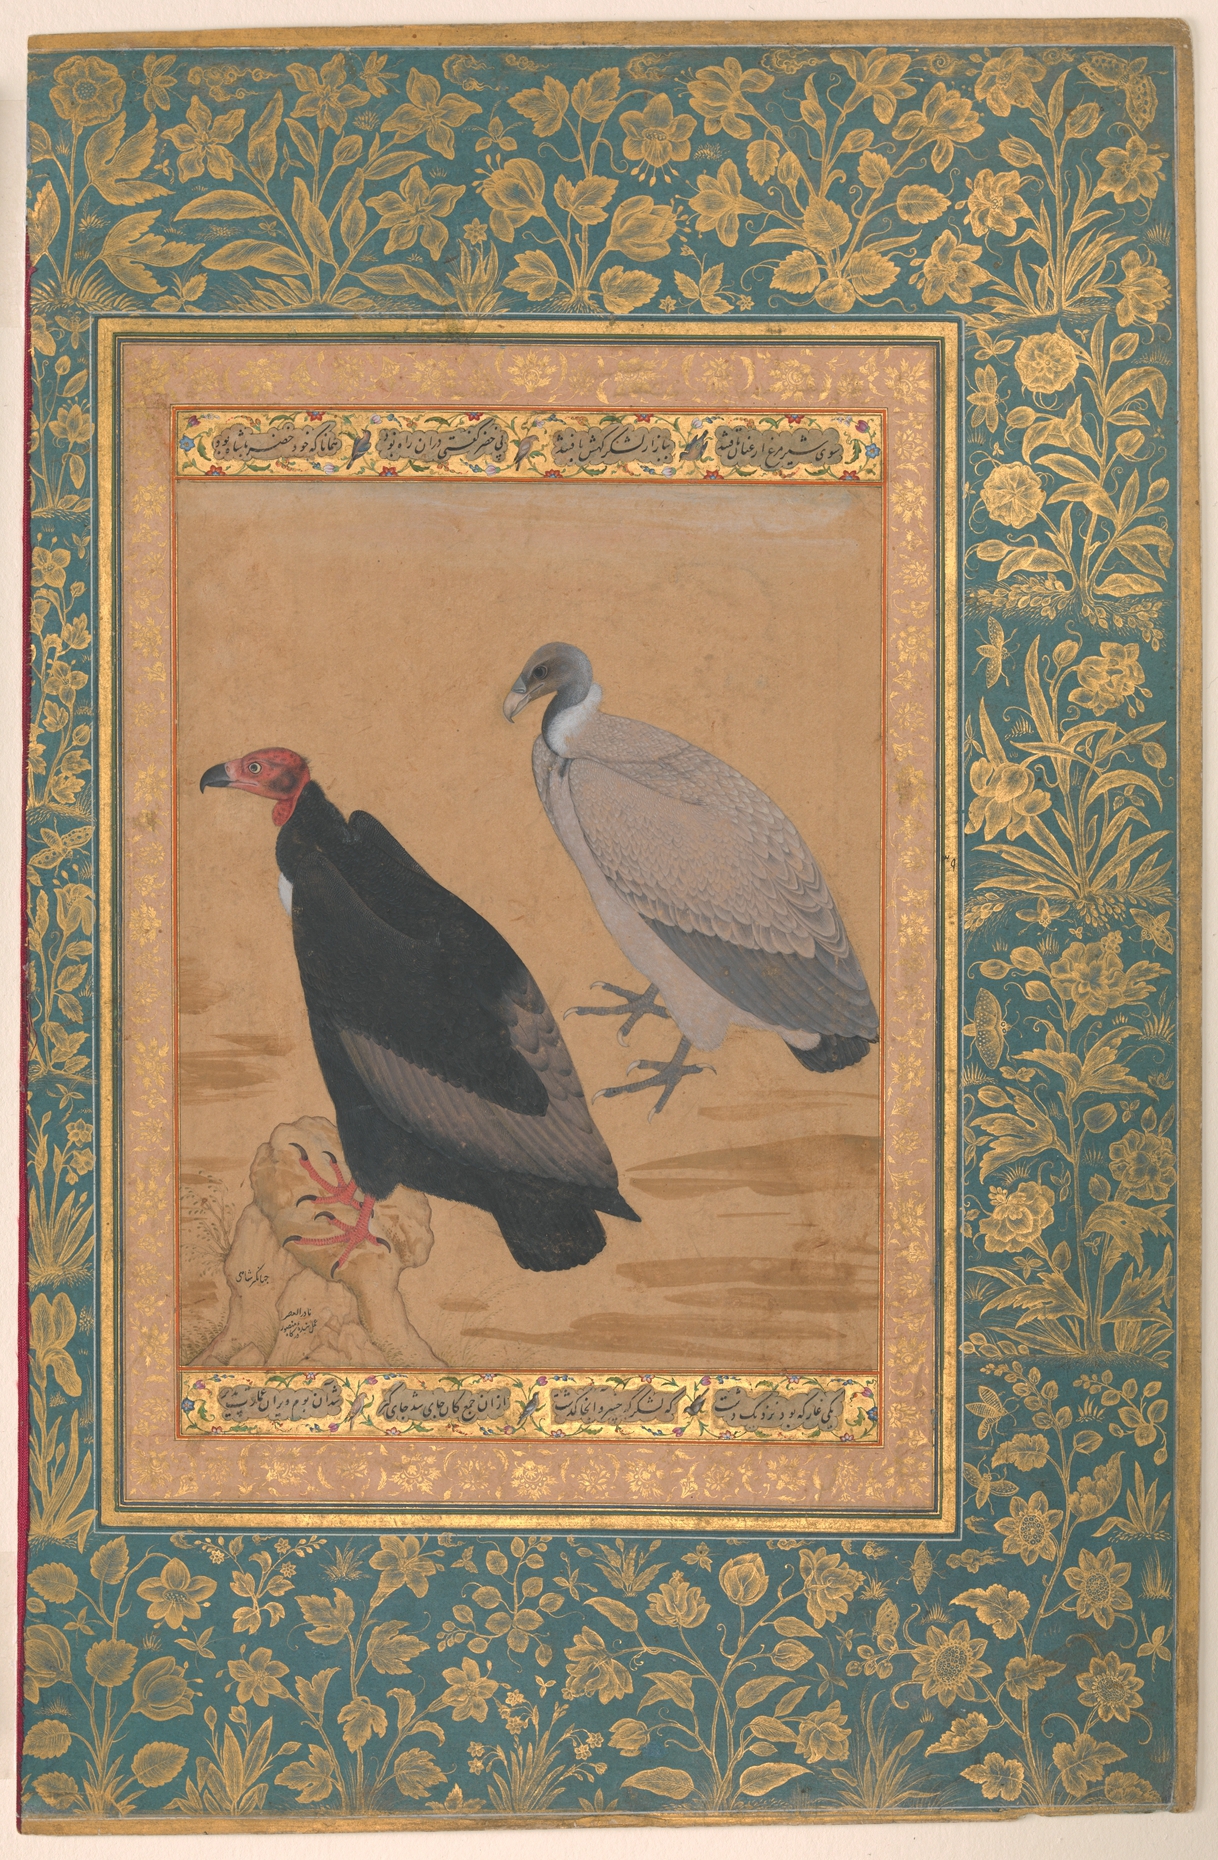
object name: album leaf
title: "Red-Headed Vulture and Long-Billed Vulture", Folio from the Shah Jahan Album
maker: mansur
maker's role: artist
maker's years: 1584-1626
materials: gold, ink, paper, watercolor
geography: india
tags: birds